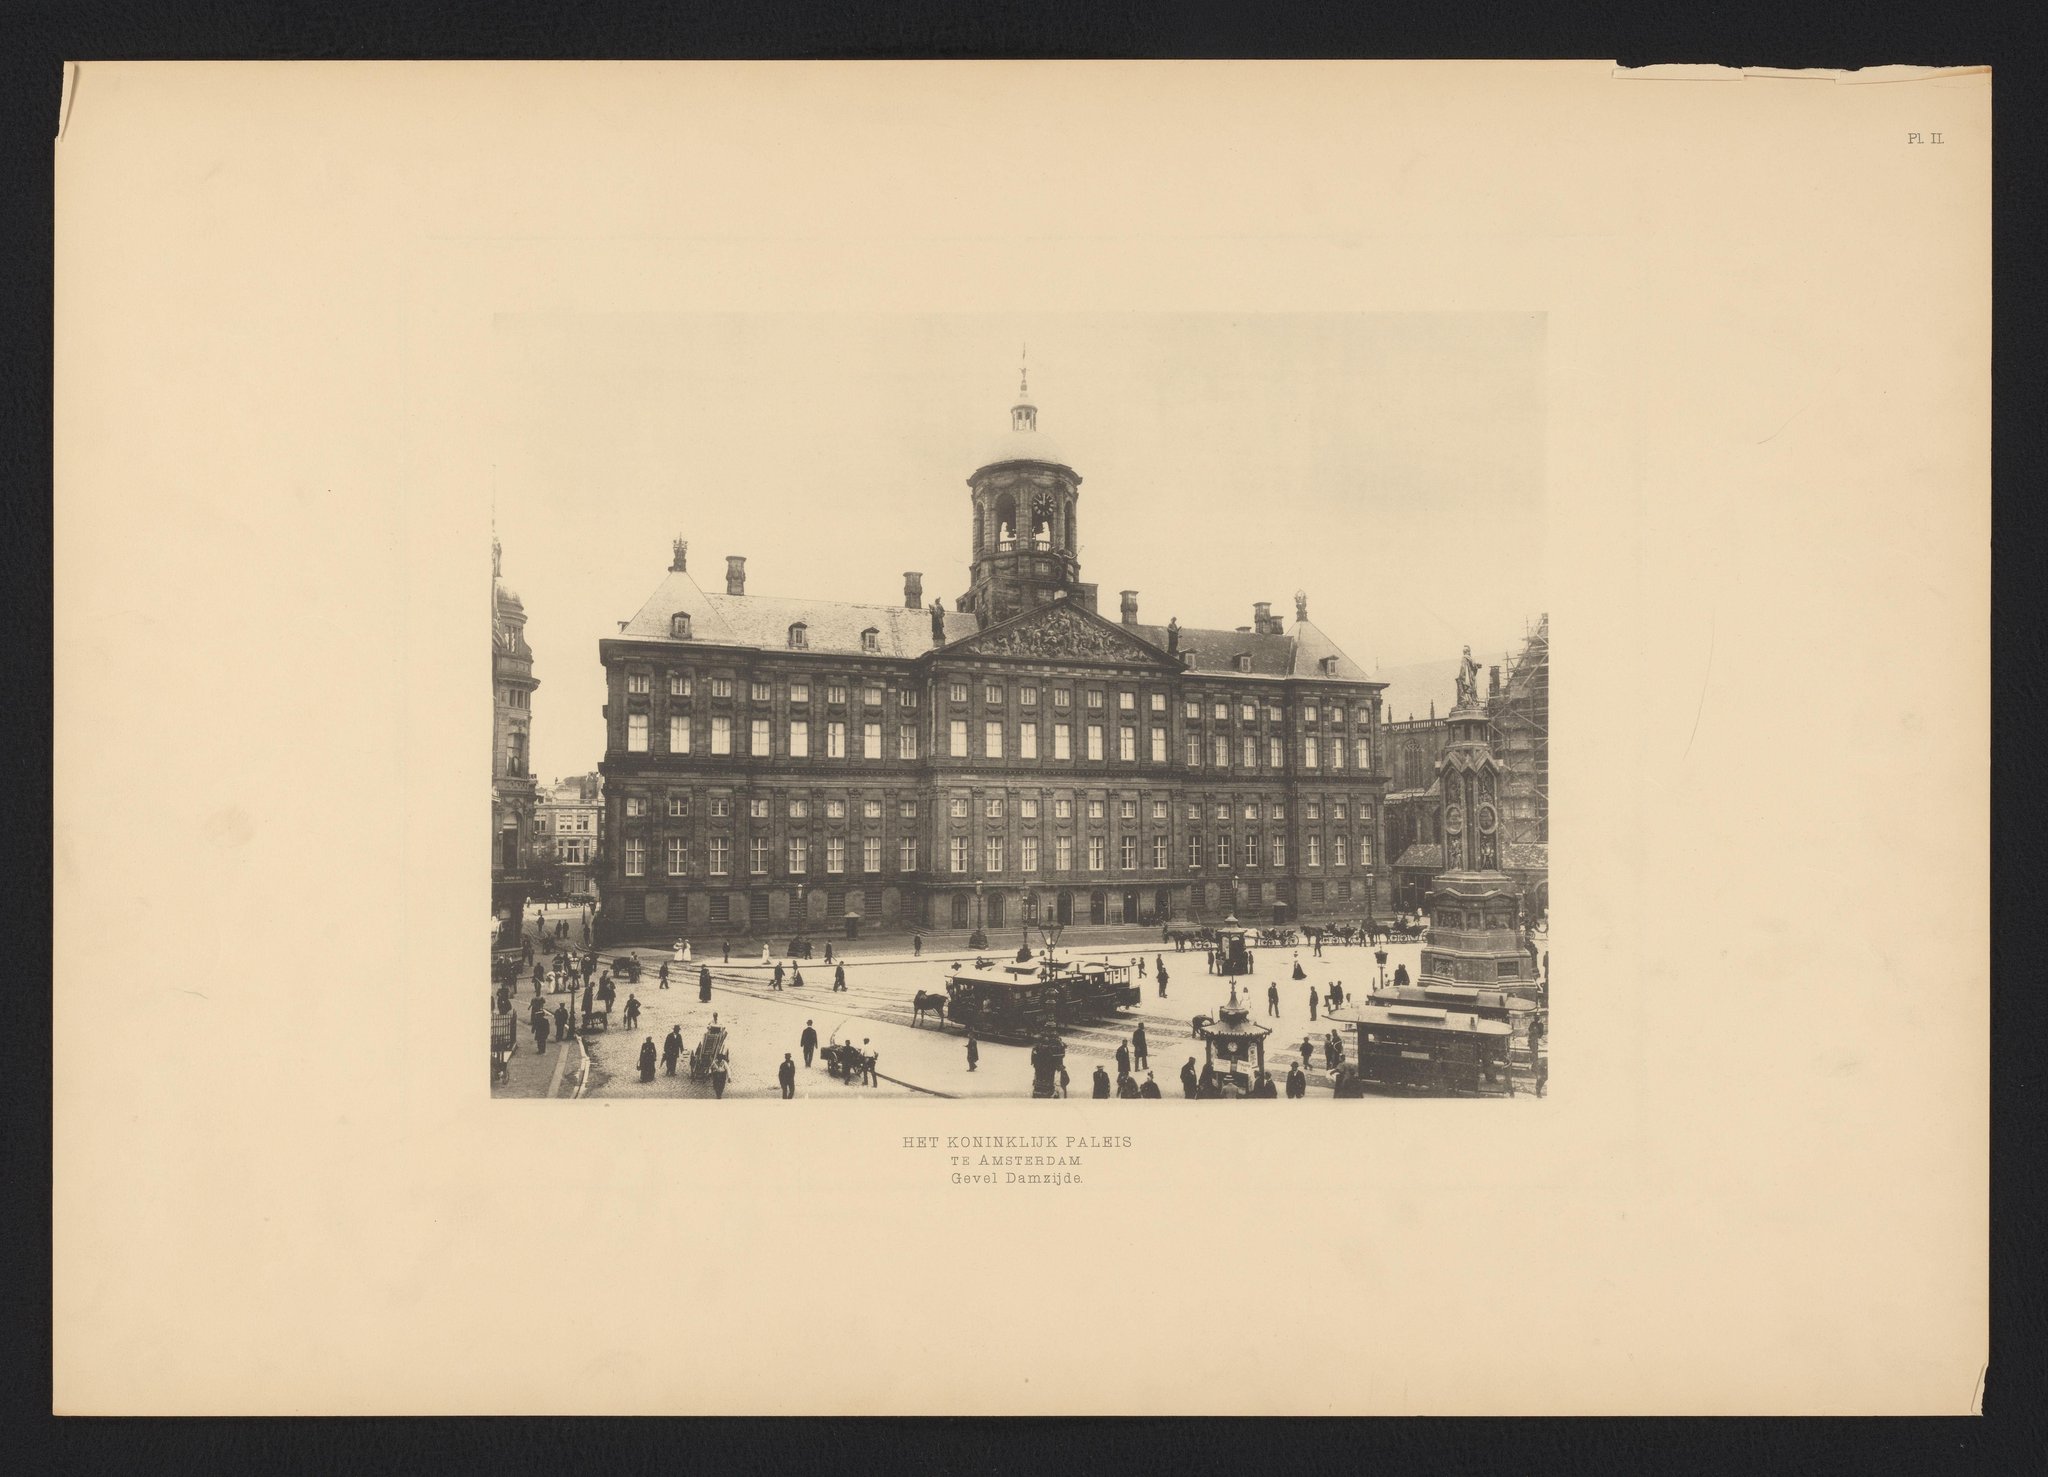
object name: photograph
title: Het Paleis op de Dam te Amsterdam in de sneeuw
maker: Anonymous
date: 1899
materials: cardboard, paper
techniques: photograph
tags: palace, royal palace of amsterdam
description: Het Koninklijk Paleis te Amsterdam. Gevel Damzijde.